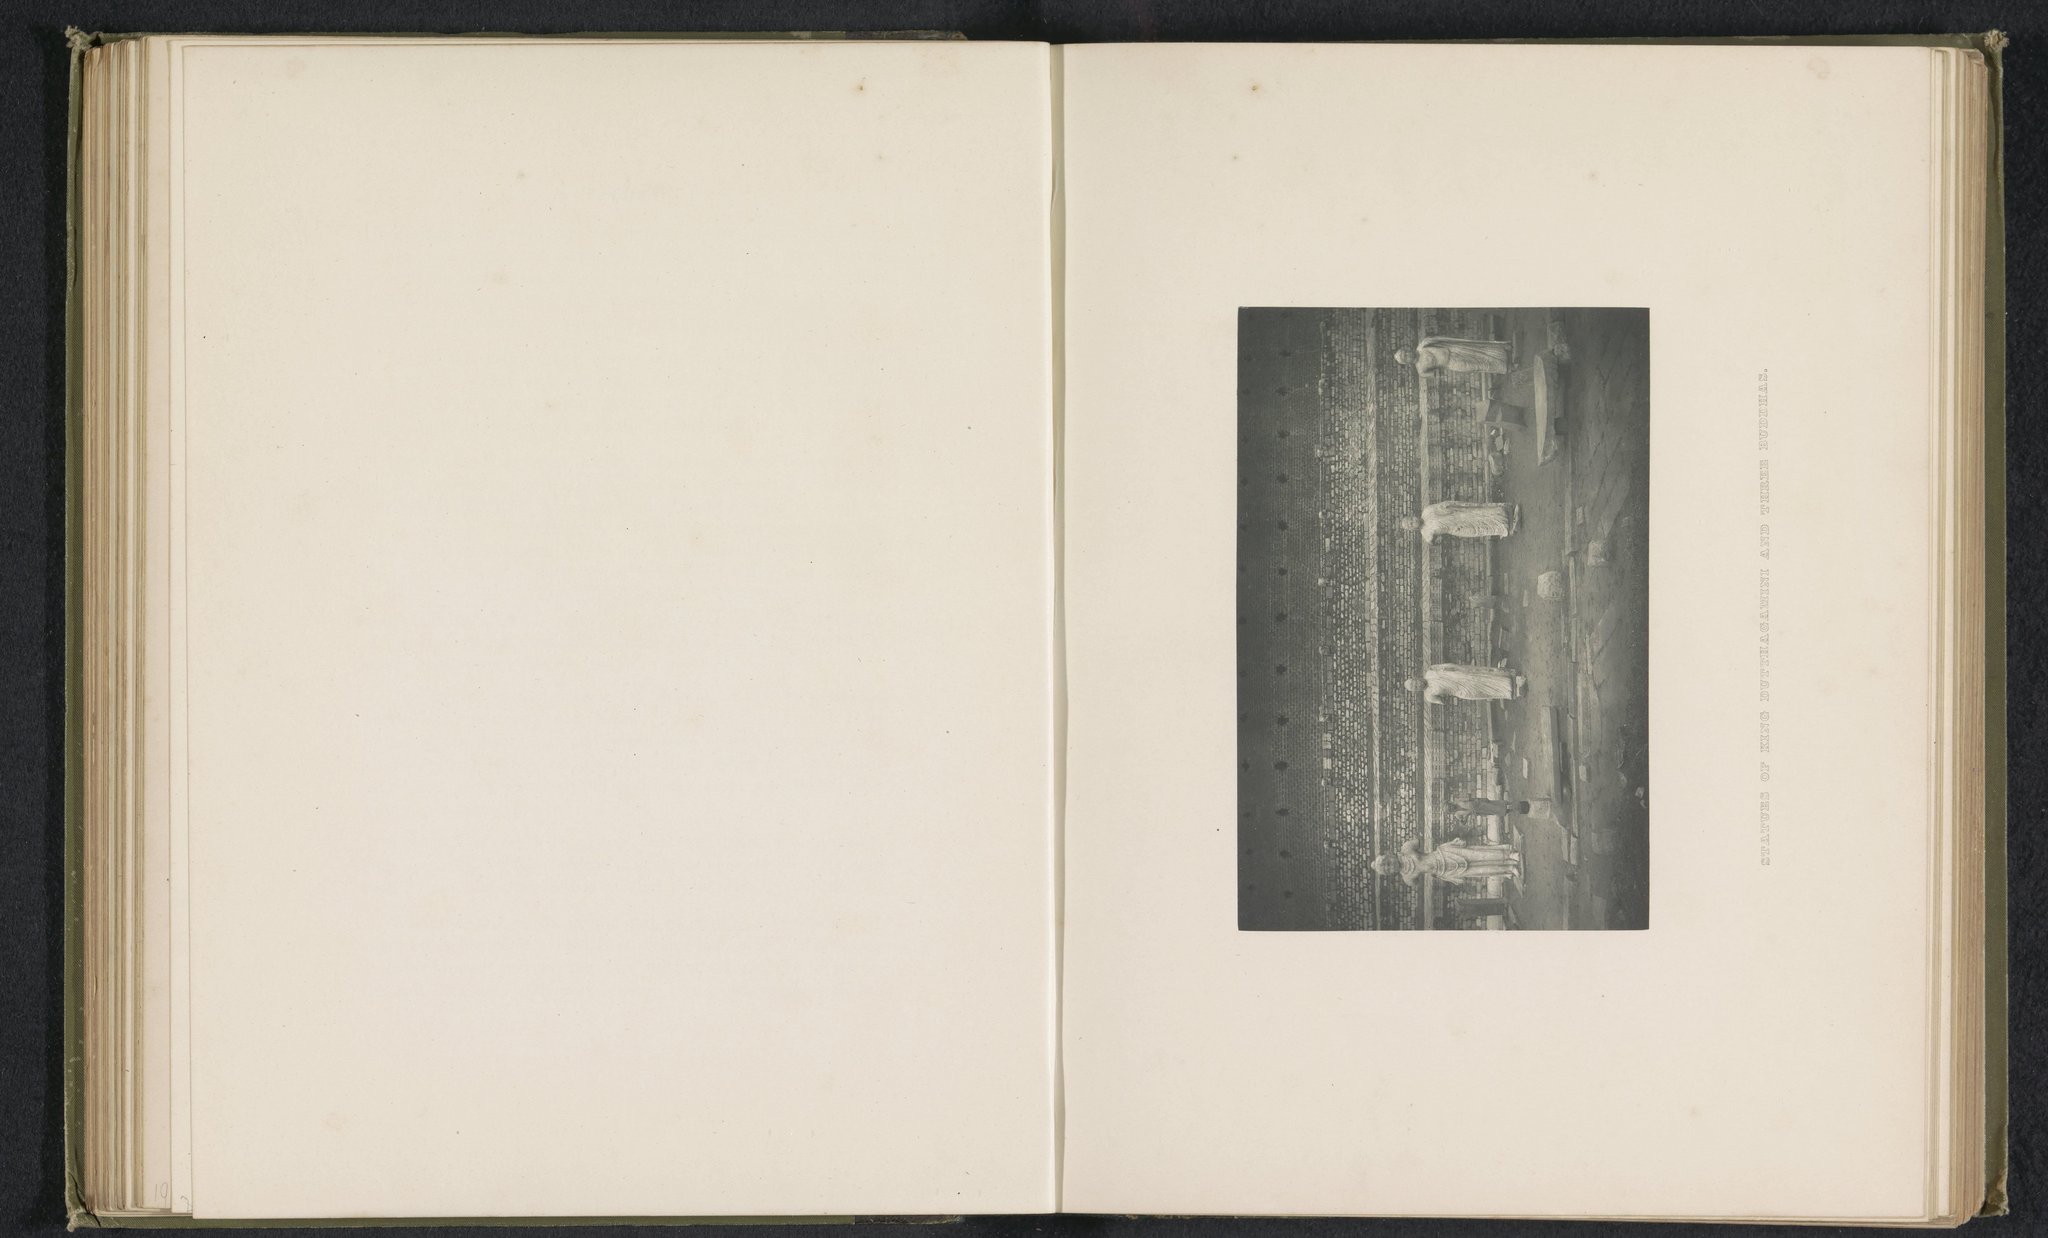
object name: page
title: Sculptures in the complex of the Ruwanwelisaya stupa at Anuradhapura, Sri Lanka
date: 1896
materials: paper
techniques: woodburygravure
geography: anuradhapura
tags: places and objects of worship ~ hinduism, buddhism, jainism, sculpture, buddha, founder of buddhism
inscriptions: title: ‘STATUES OF KING DUTTHAGAMINI AND THREE BUDDHAS.’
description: Voorstellende zijn koning Dutugamunu en drie Boeddha's